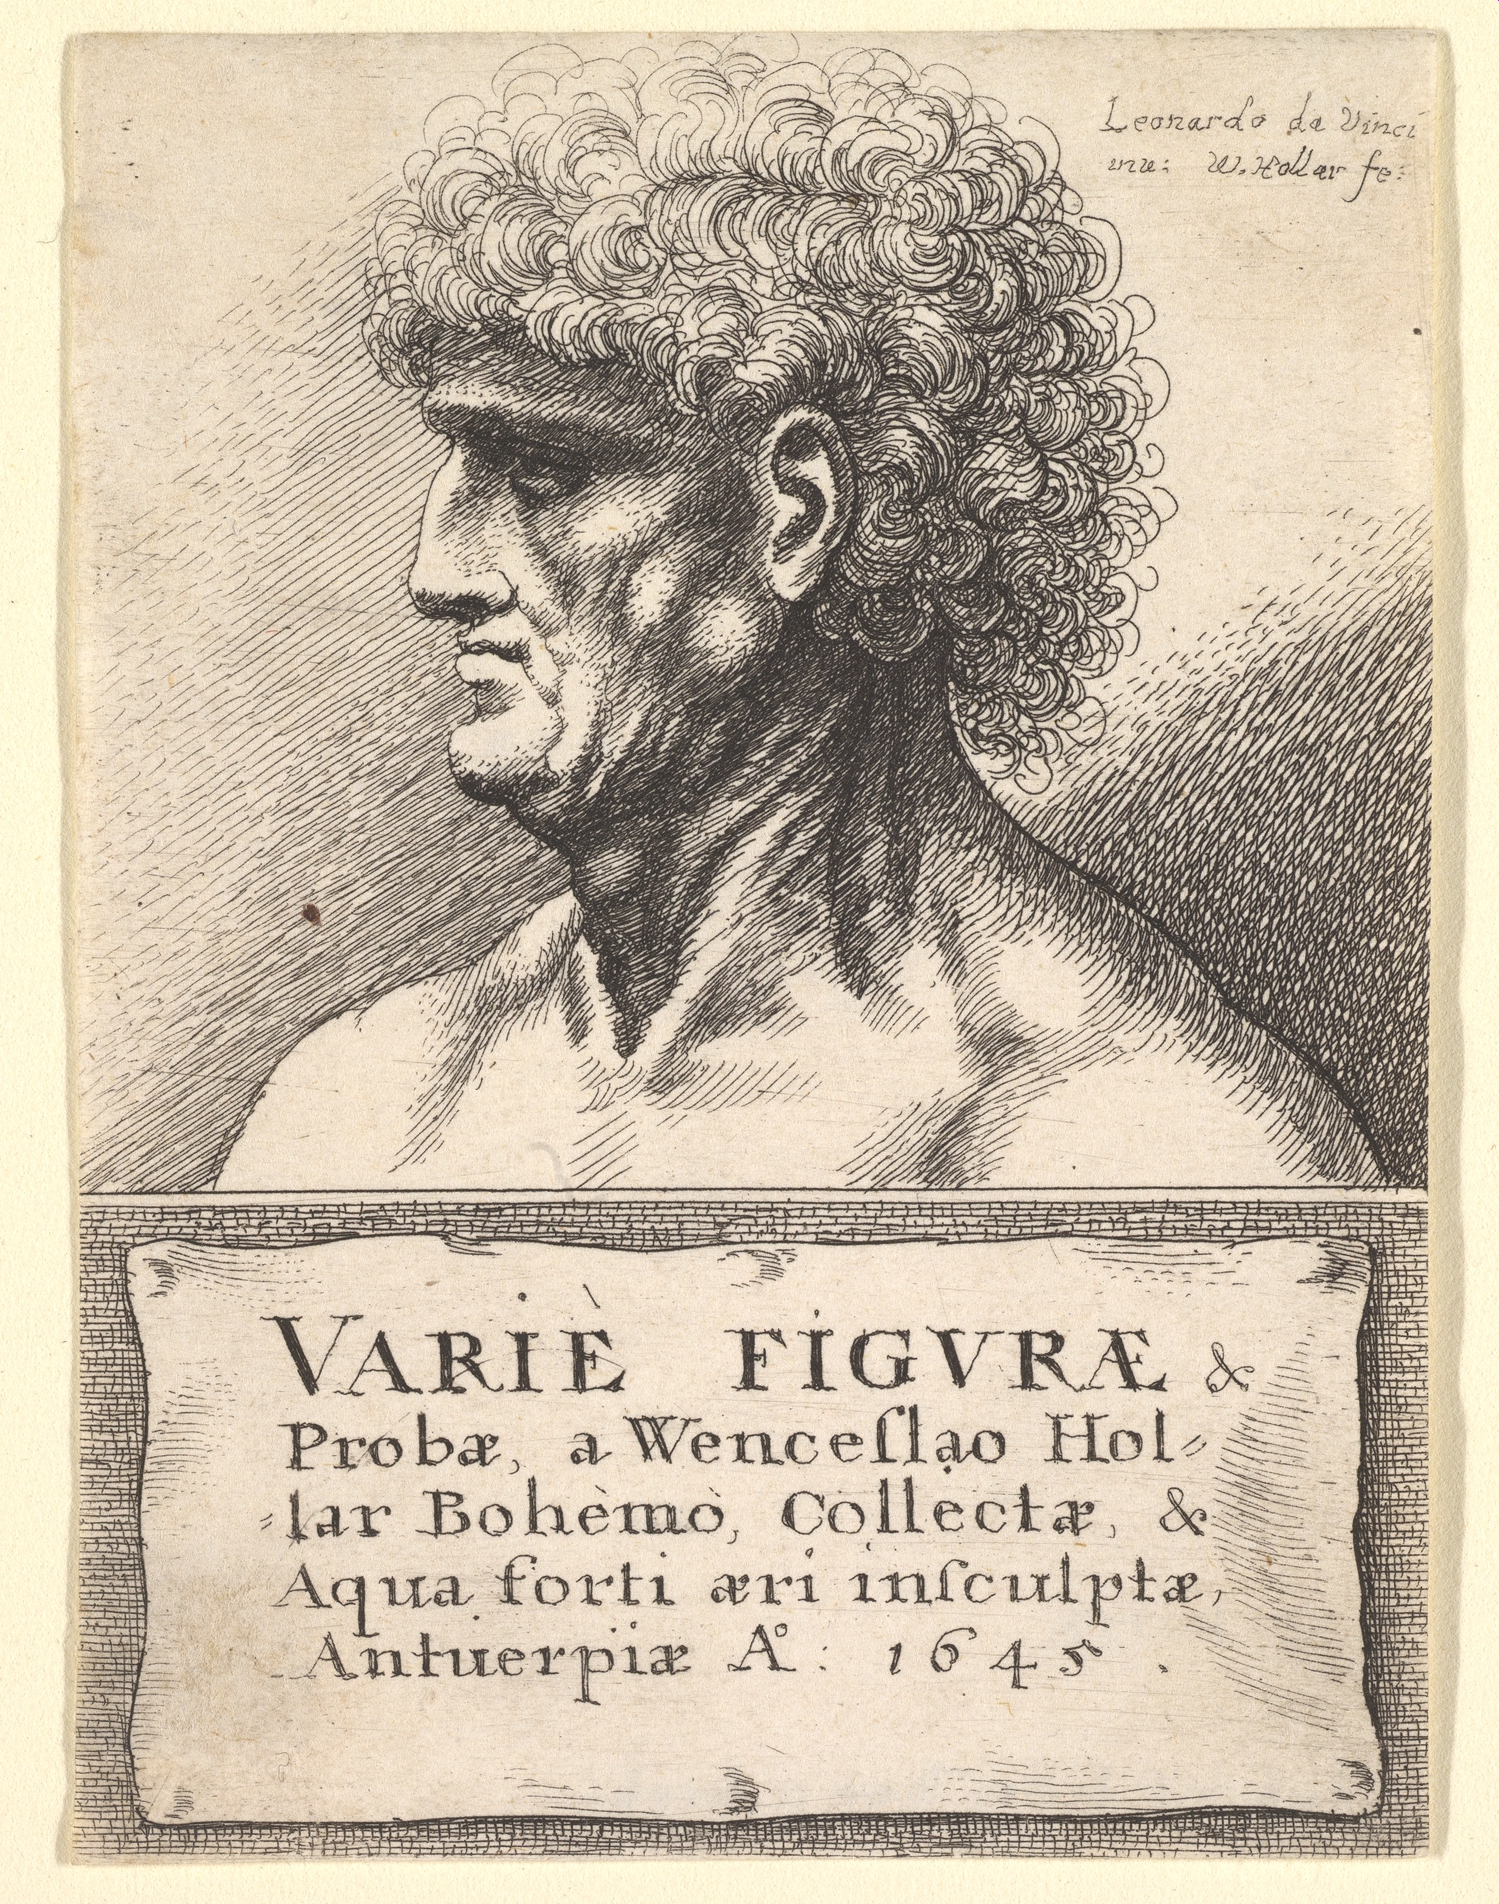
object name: print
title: Title-page to "Varie Figuræ & Probæ"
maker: wenceslaus hollar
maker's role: artist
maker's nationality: bohemian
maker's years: 1607-1677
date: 1645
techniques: etching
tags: men